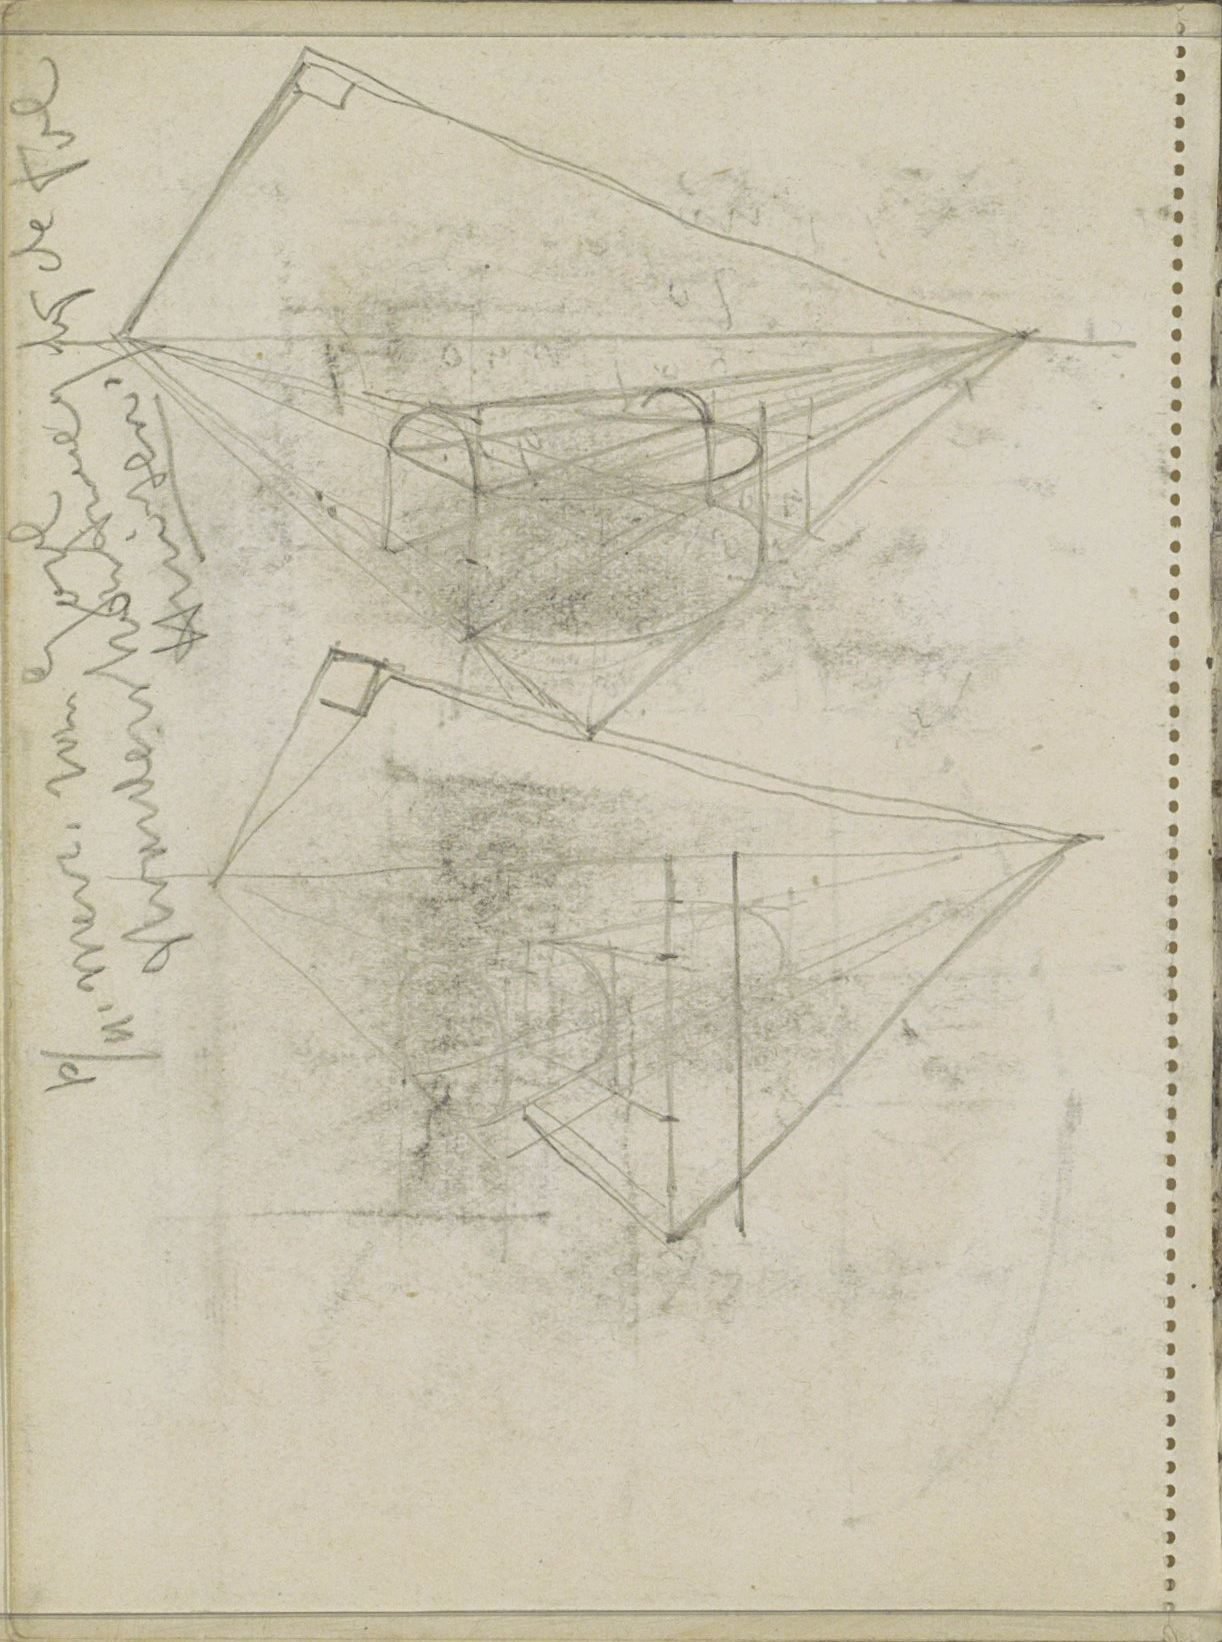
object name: sketchbook leaf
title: Perspectieftekening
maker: reijer stolk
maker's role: draughtsman, print maker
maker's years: 1896-1945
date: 1906-1945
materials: paper, pencil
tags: mathematical perspective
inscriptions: annotation: ‘p/a mevr van Joul/ Naarder[...]houtweg bij de tol/ Huizen’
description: Blad 53 verso uit een schetsboek met 53 bladen.